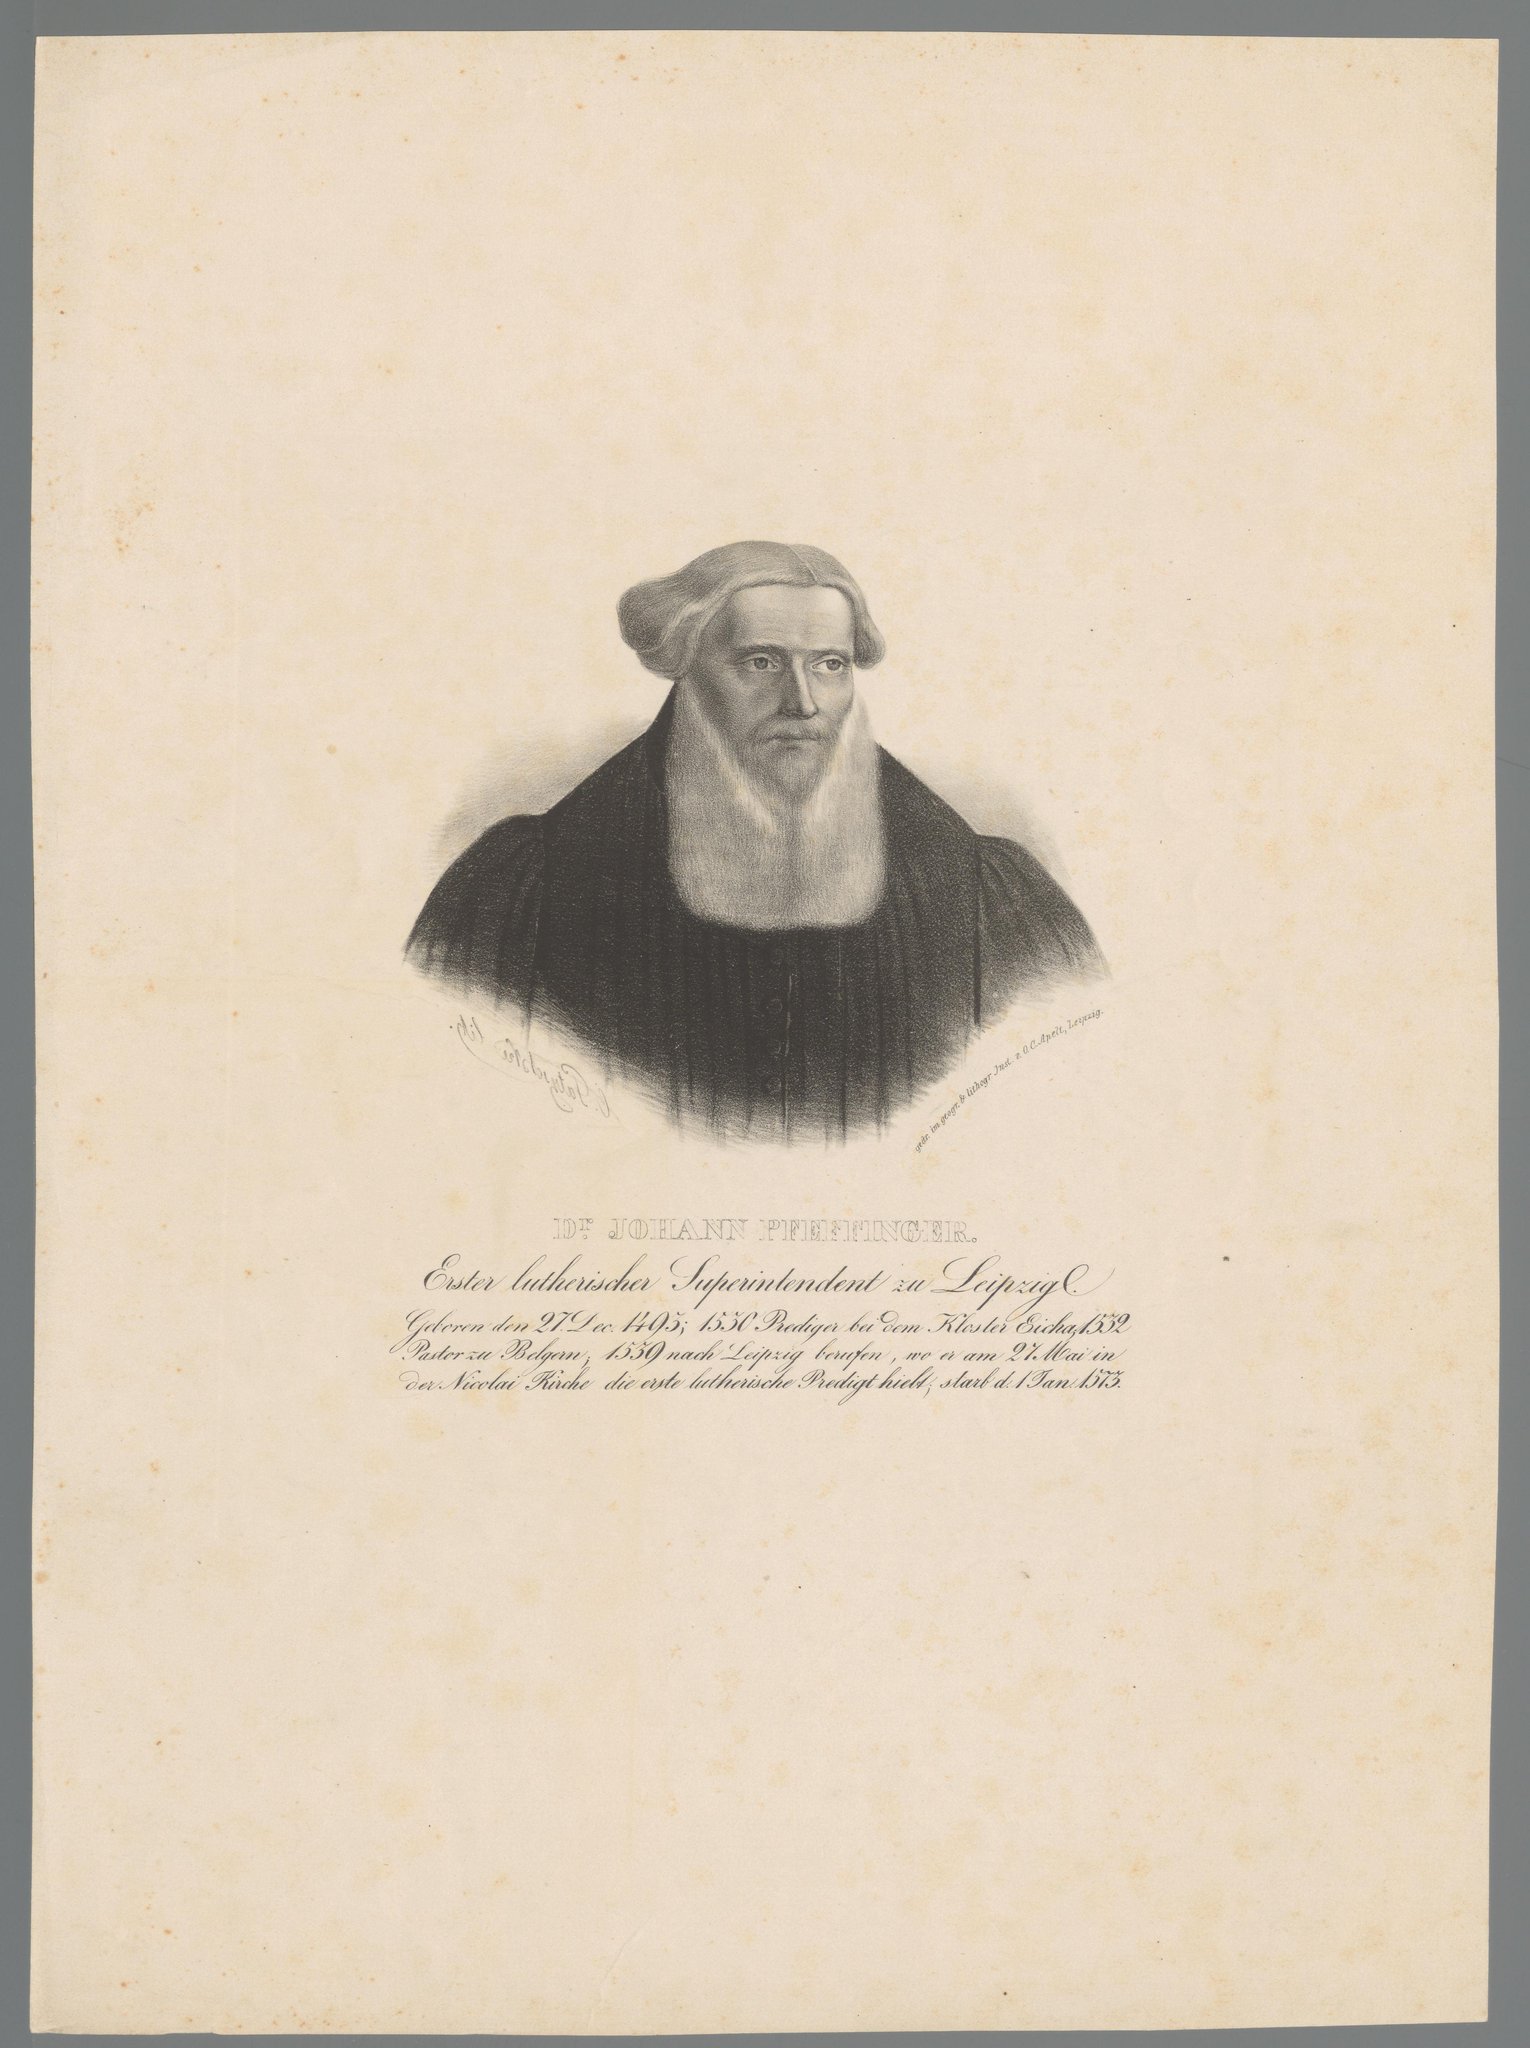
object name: print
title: Portret van Johann Pfeffinger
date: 1823-1871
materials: paper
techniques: lithograph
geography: leipzig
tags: adult man, historical persons, beard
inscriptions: collector's mark: Lugt 2228